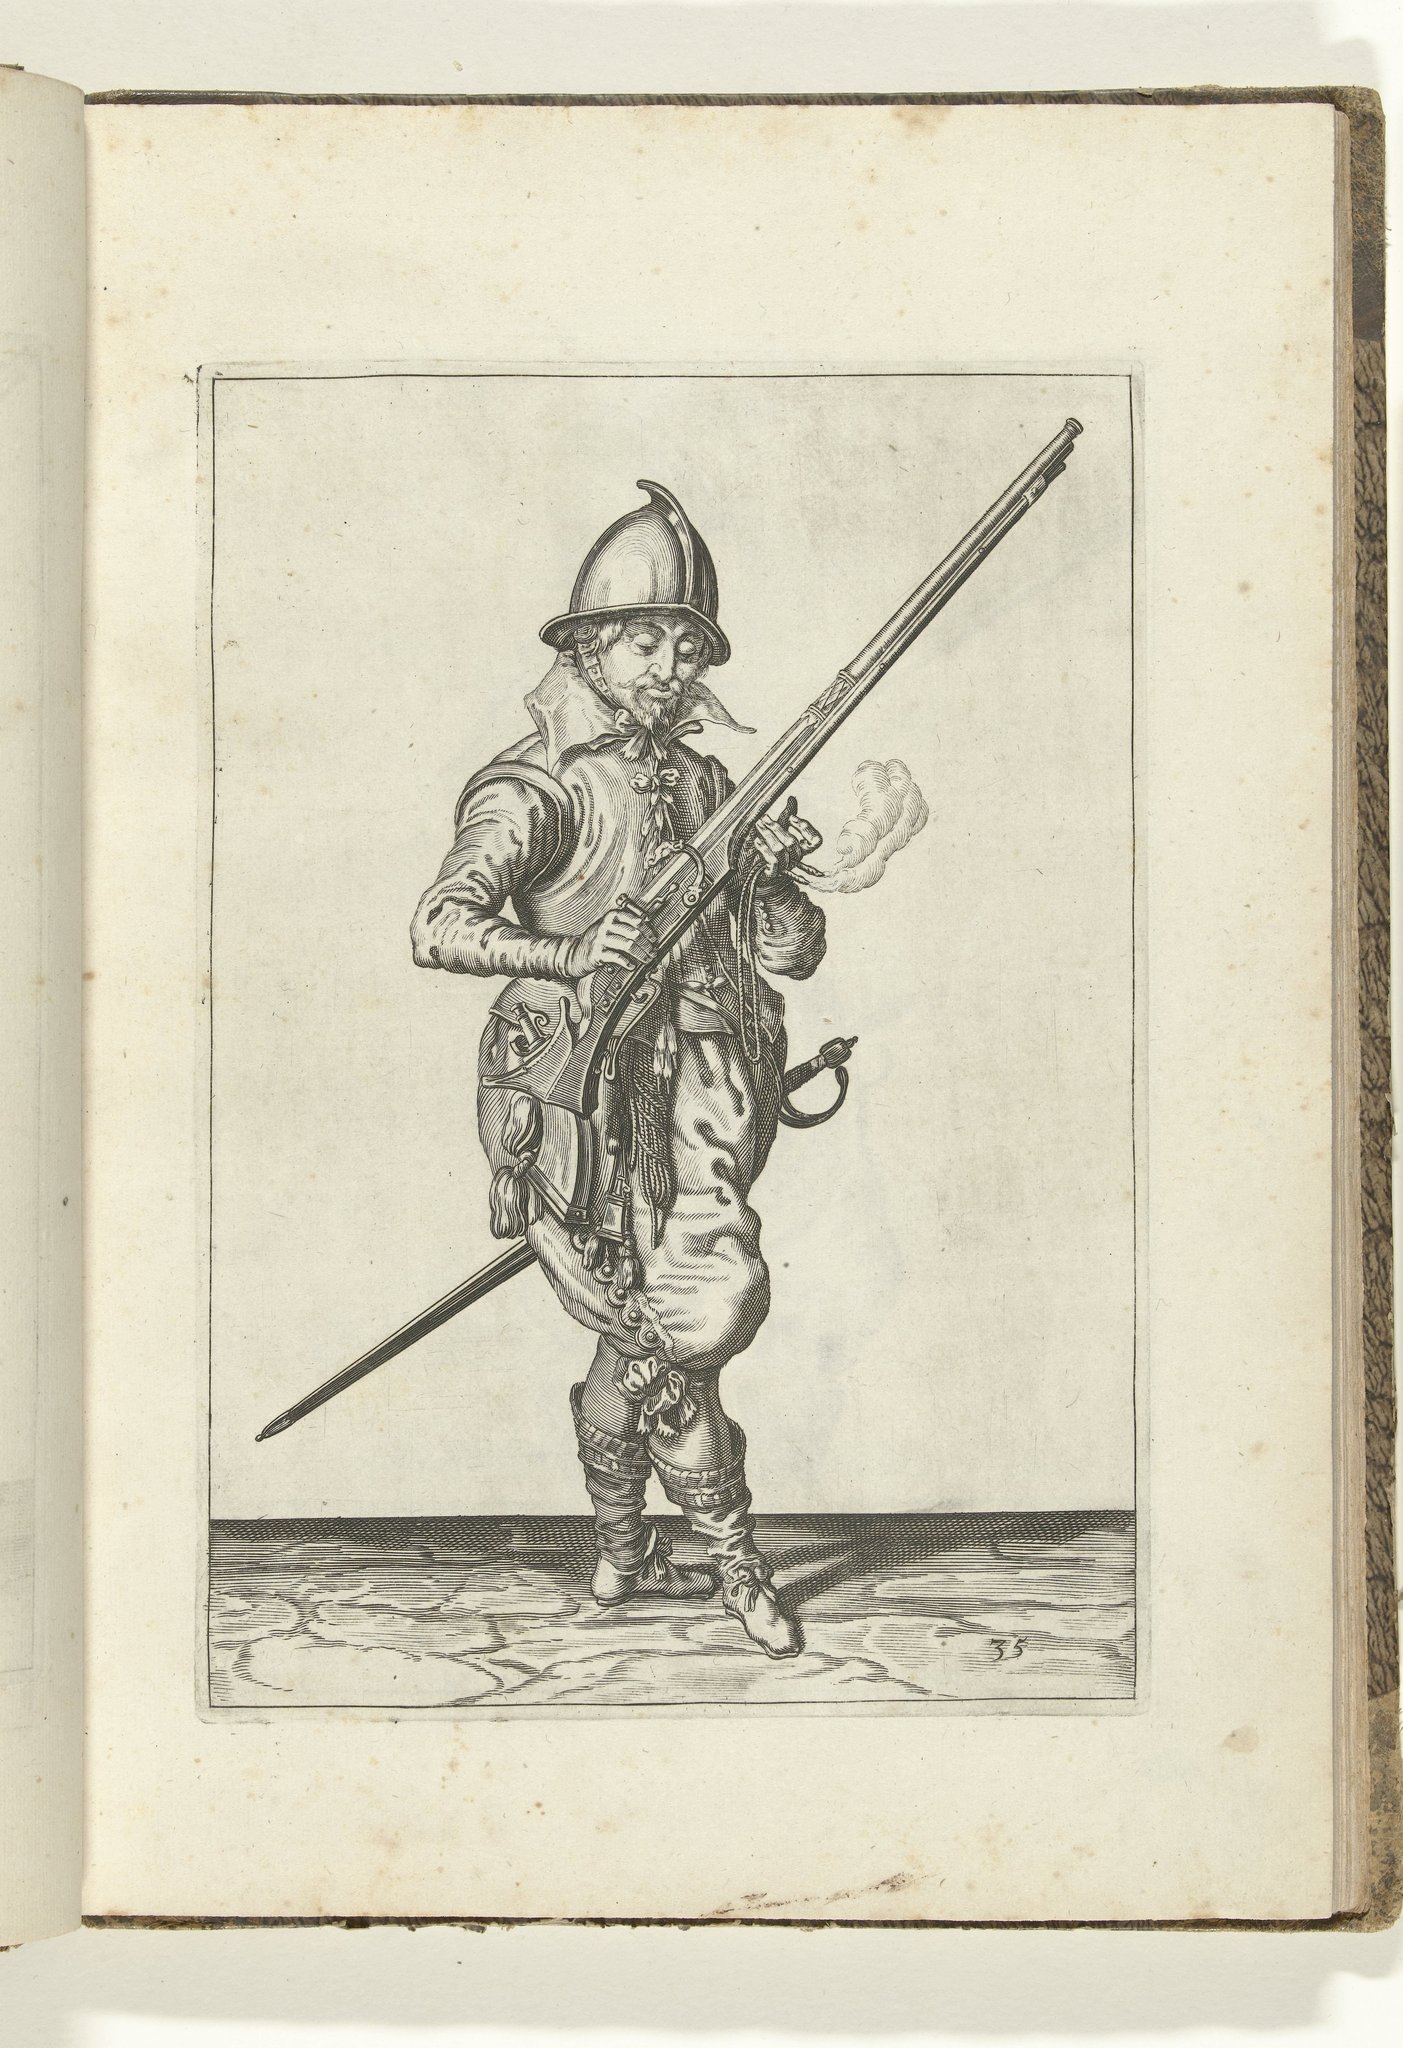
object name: print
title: Soldaat op wacht die zijn roer met zijn rechterhand schuin omhoog gericht vasthoudt, terwijl hij de loop in zijn linkerhand laat vallen (nr. 35), ca. 1600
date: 1597-1608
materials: paper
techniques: engraving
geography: northern netherlands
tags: maurice (prince of orange), handling of weapons ~ military training, weapons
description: Een soldaat op wacht, ten voeten uit, naar rechts, die een roer (een bepaald type vuurwapen) met zijn rechterhand vasthoudt, de loop schuin omhoog gericht (nr. 35), ca. 1600. Hij laat de loop juist in zijn linkerhand vallen, waarin ook een brandende lont. Plaat 35 in de instructies voor het hanteren van de roer: Brief enseignement, sur la representation des figures, du droit maniement de l'Harquebuse. Onderdeel van de illustraties in een Franse editie van J. de Gheyns Wapenhandelinghe: J. de Gheyn, Maniement d'armes, d'arquebuses, mousquetz et piques : en conformité de l'ordre de Mour le Prince Maurice, Prince d'Orange, Amsterdam 1608. Krijgswezen rond 1600.